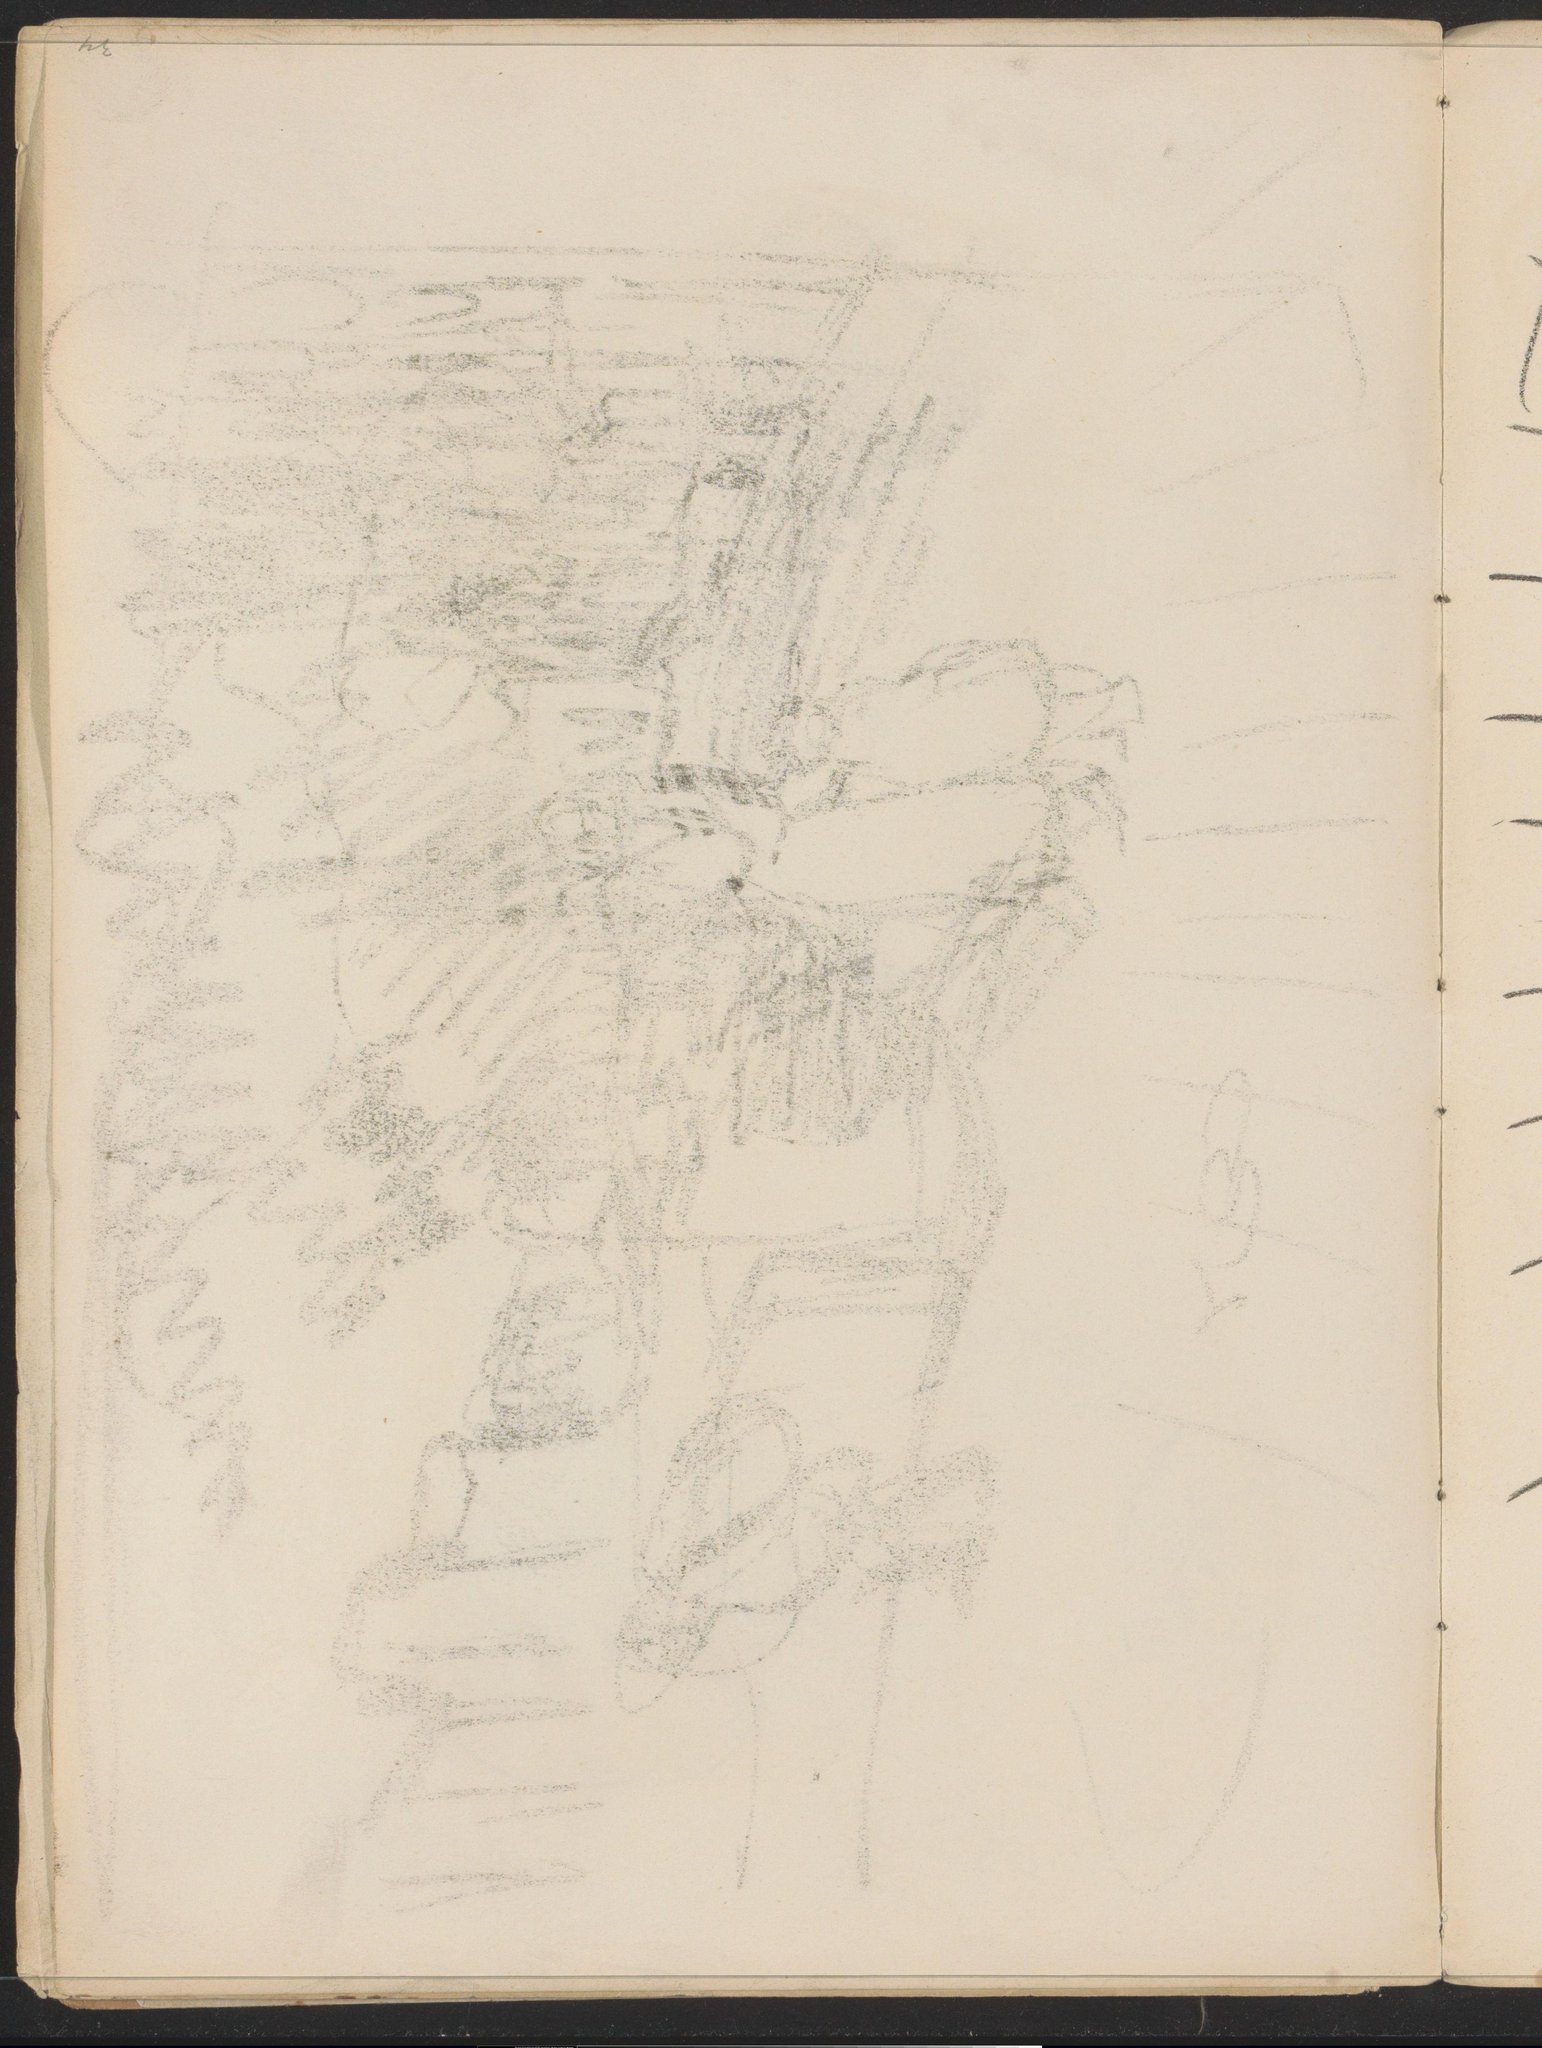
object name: sketchbook leaf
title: Abklatsch van de krijttekening op blad 18 recto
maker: isaac israels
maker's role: draughtsman, painter, print maker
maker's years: 1865-1934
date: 1886-1934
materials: paper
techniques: printmaking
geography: amsterdam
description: Blad 17 verso uit schetsboek LXVI-B met 25 bladen.